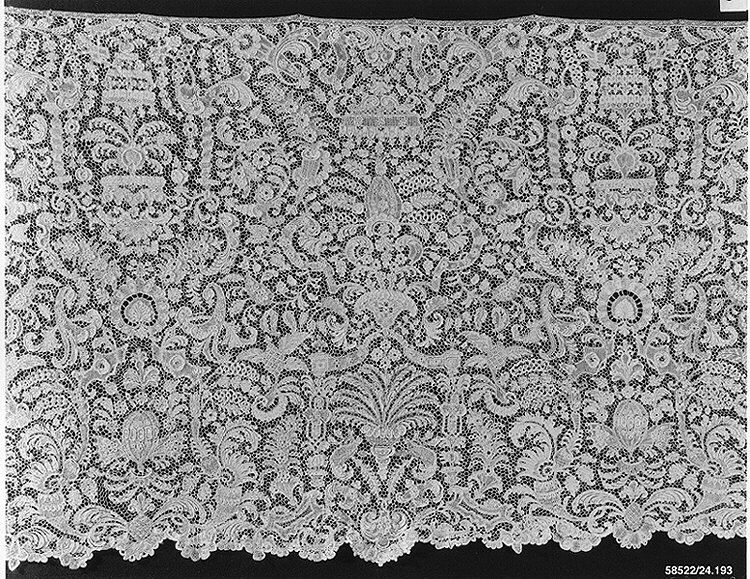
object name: flounce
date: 1601-1700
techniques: lace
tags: flowers